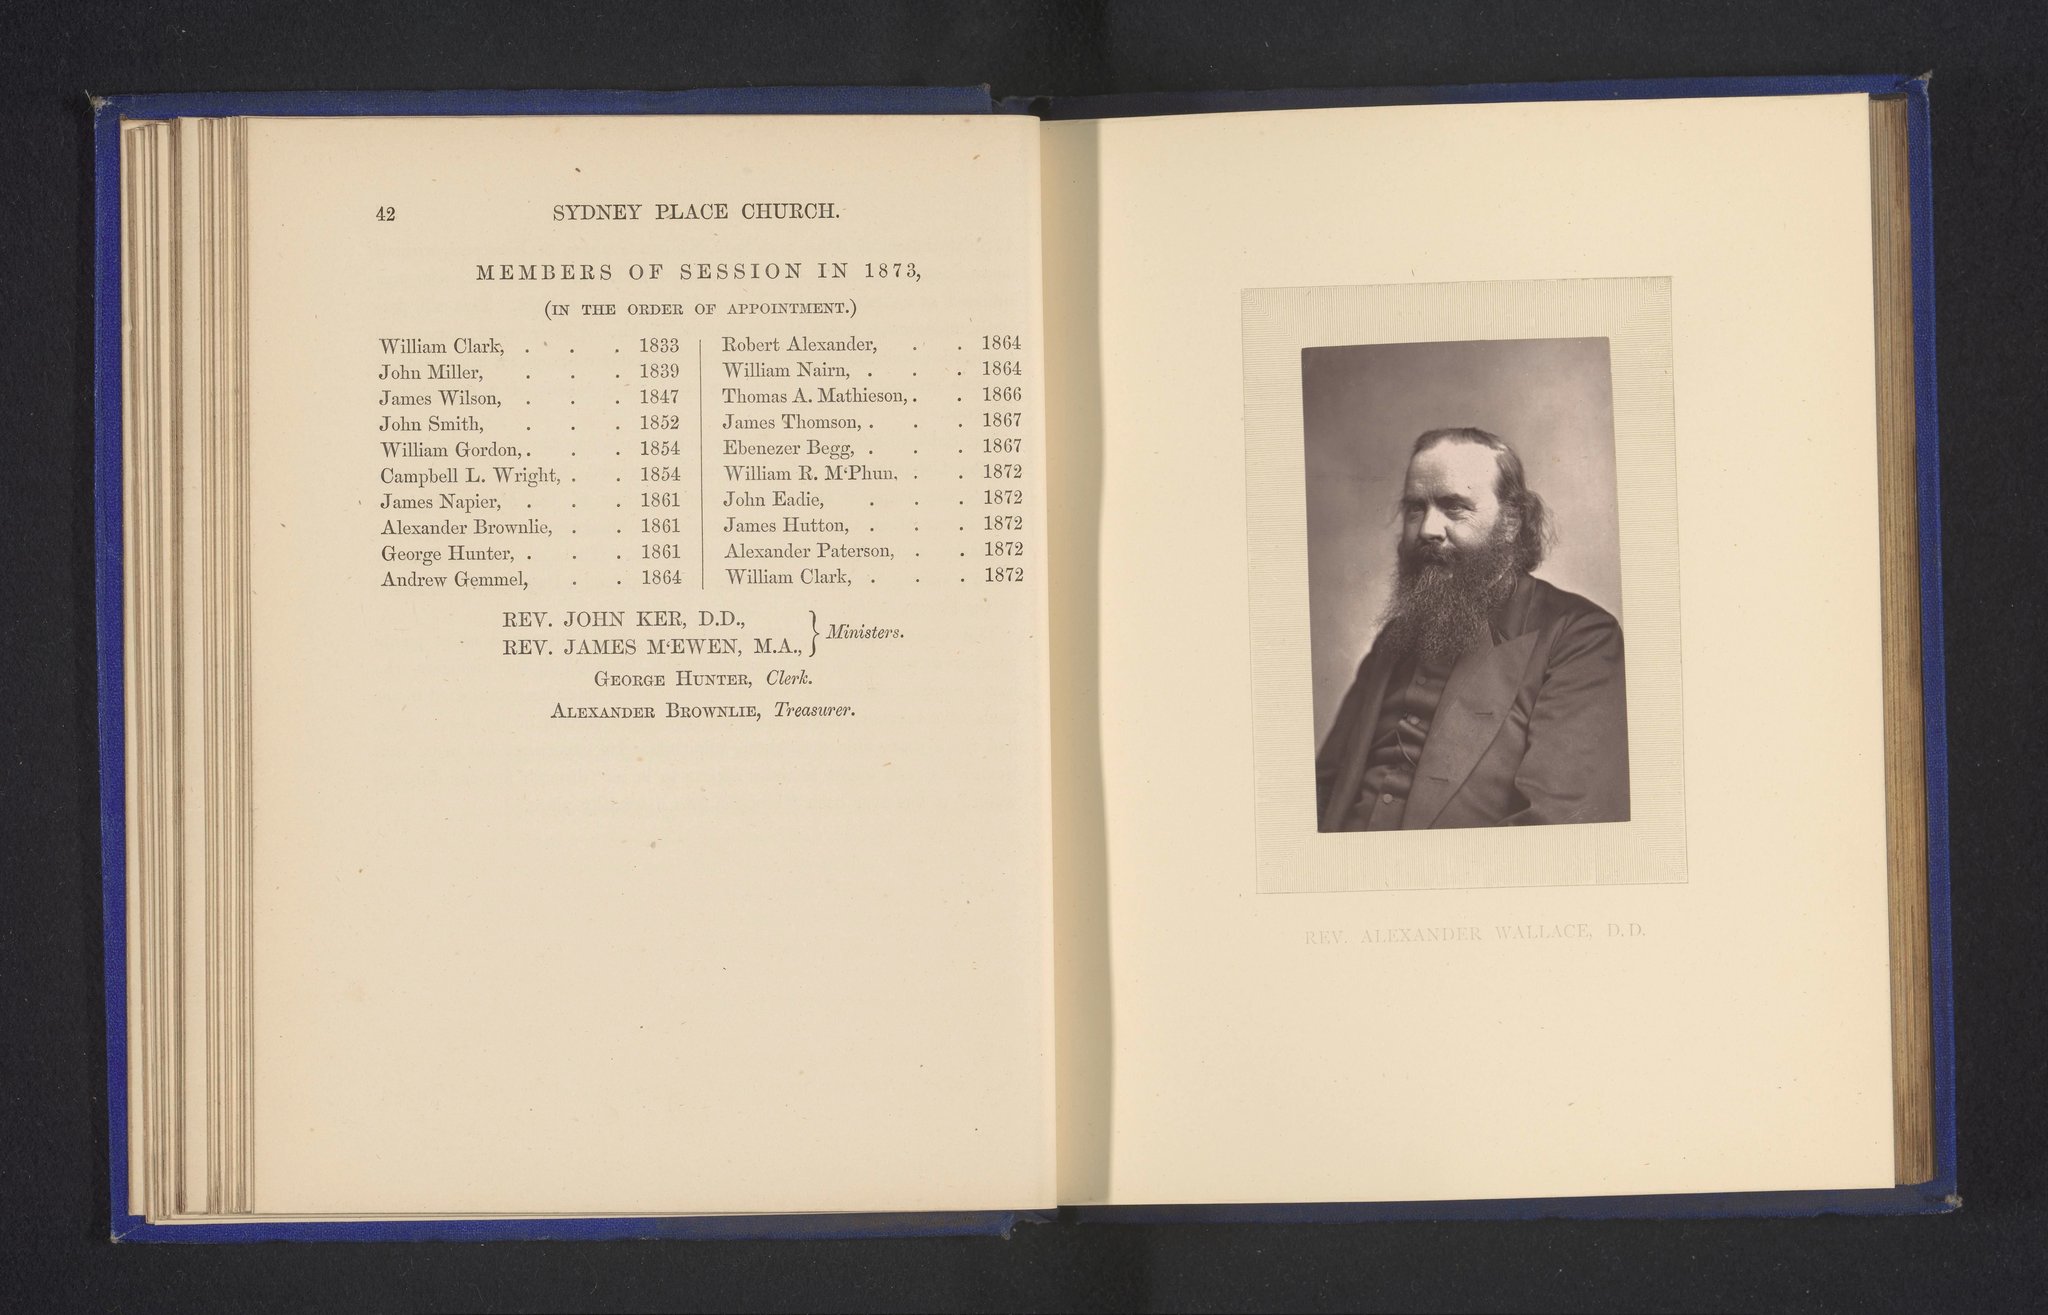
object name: page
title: Portret van Alexander Wallace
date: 1865-1875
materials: paper, photographic support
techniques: carbon print, woodburytype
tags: functionaries and dignitaries (with name) ~ protestant churches